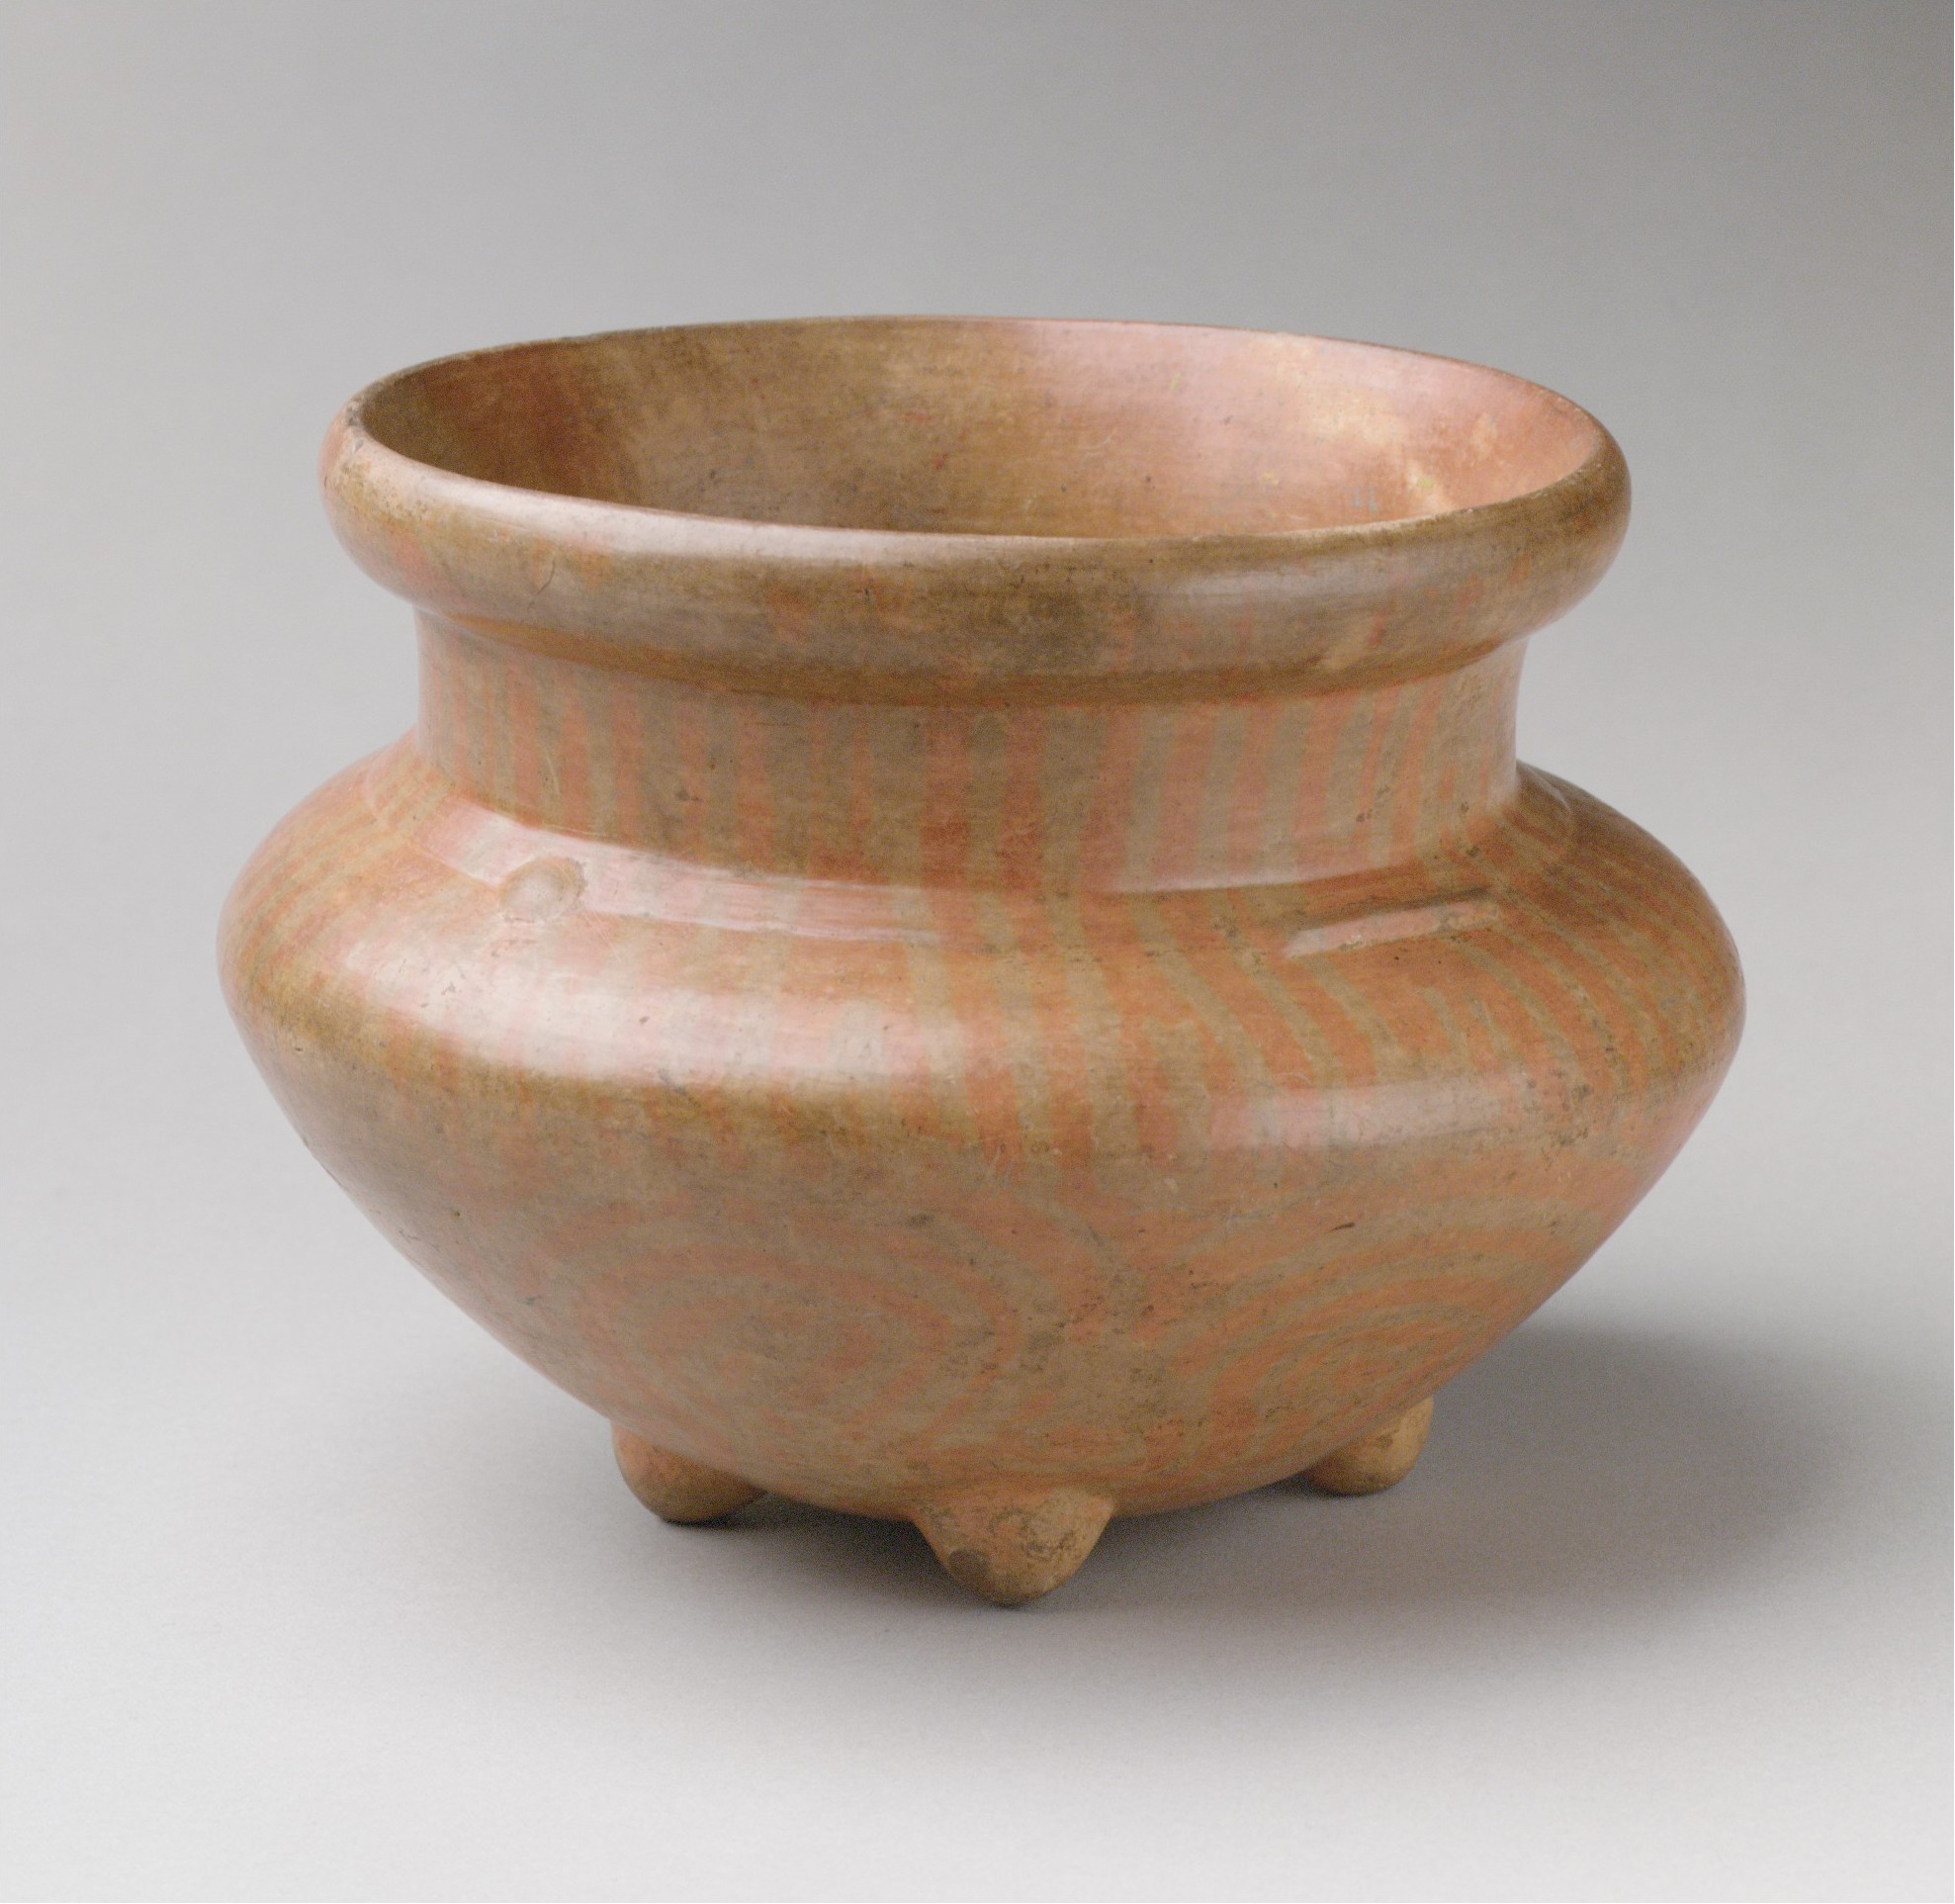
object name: bowl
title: Tetrapod Jar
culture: maya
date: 200 BCE-1 CE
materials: ceramic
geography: el salvador